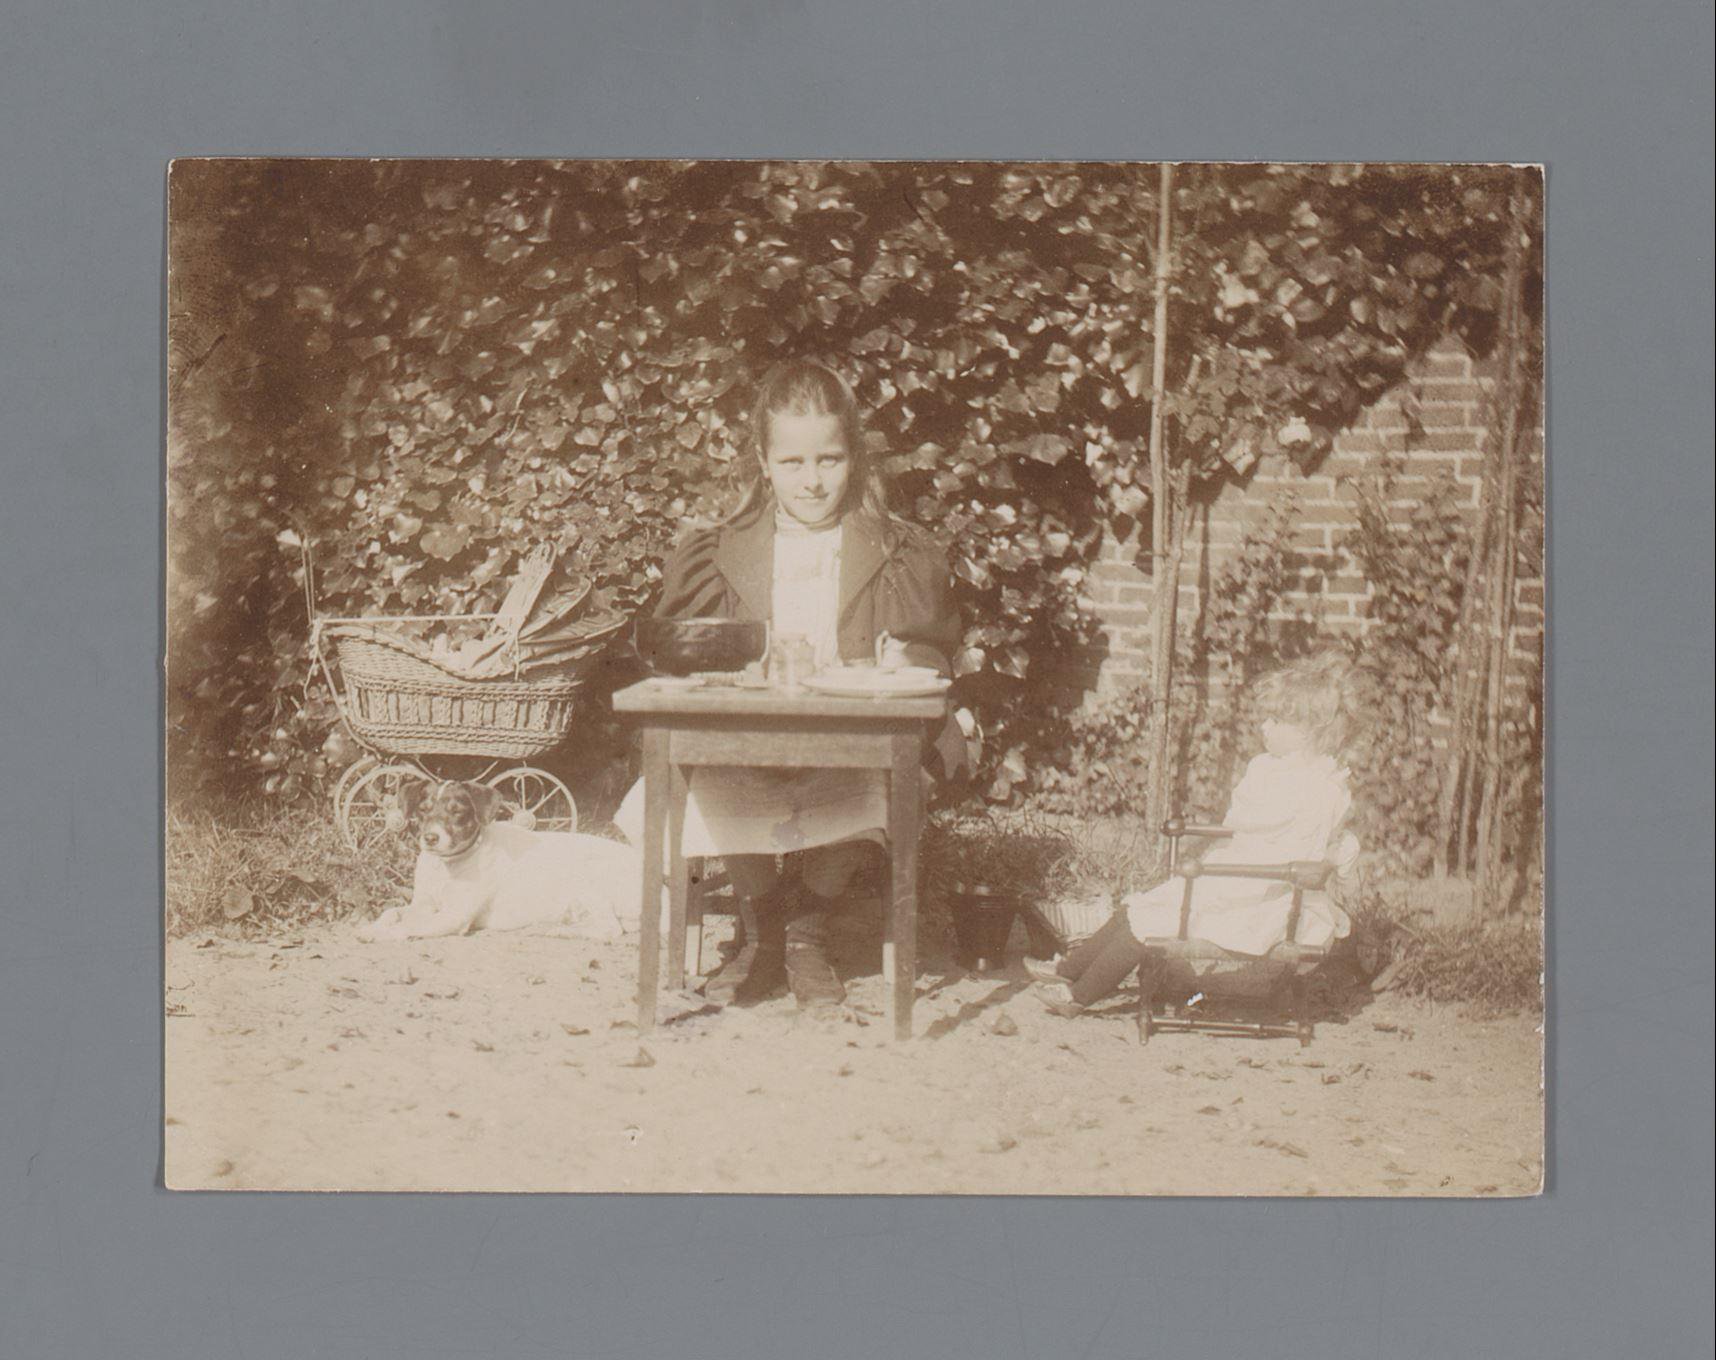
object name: photograph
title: Portret van Johanna Geertruida Jonker met theeservies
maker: cornelia hendrika jonker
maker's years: 1874-1924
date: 1895-1910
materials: photographic support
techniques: collodion silver print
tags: toy tea-set, historical persons, (playing with) dolls, dog